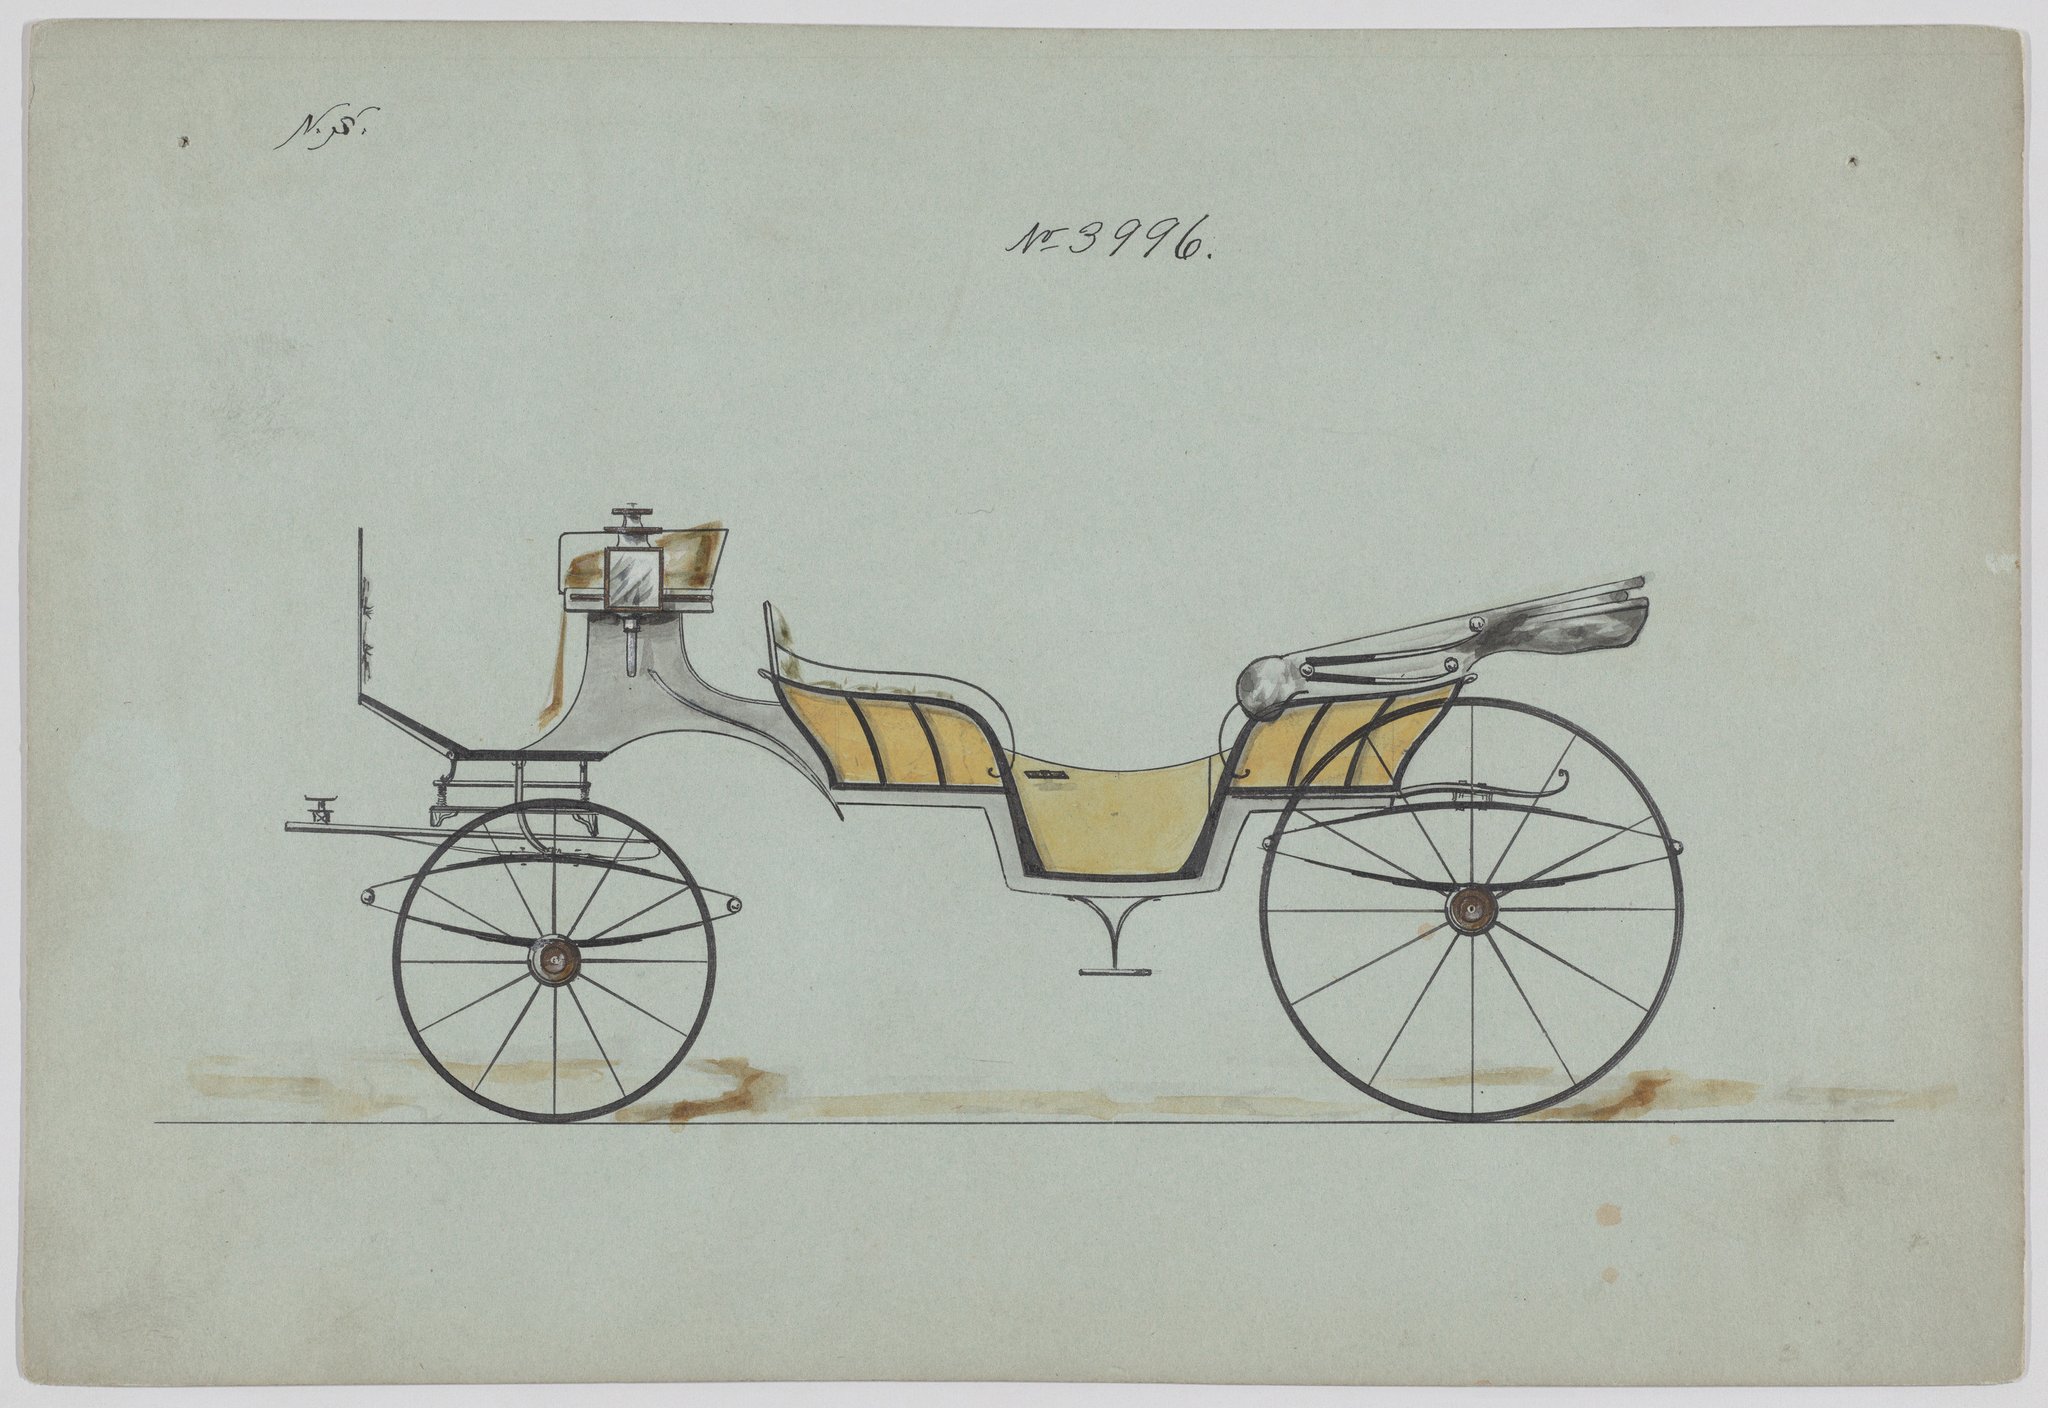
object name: drawing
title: Vis-à-vis #3996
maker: brewster & co.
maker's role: manufacturer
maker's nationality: american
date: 1887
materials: ink, watercolor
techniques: pen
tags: carriages